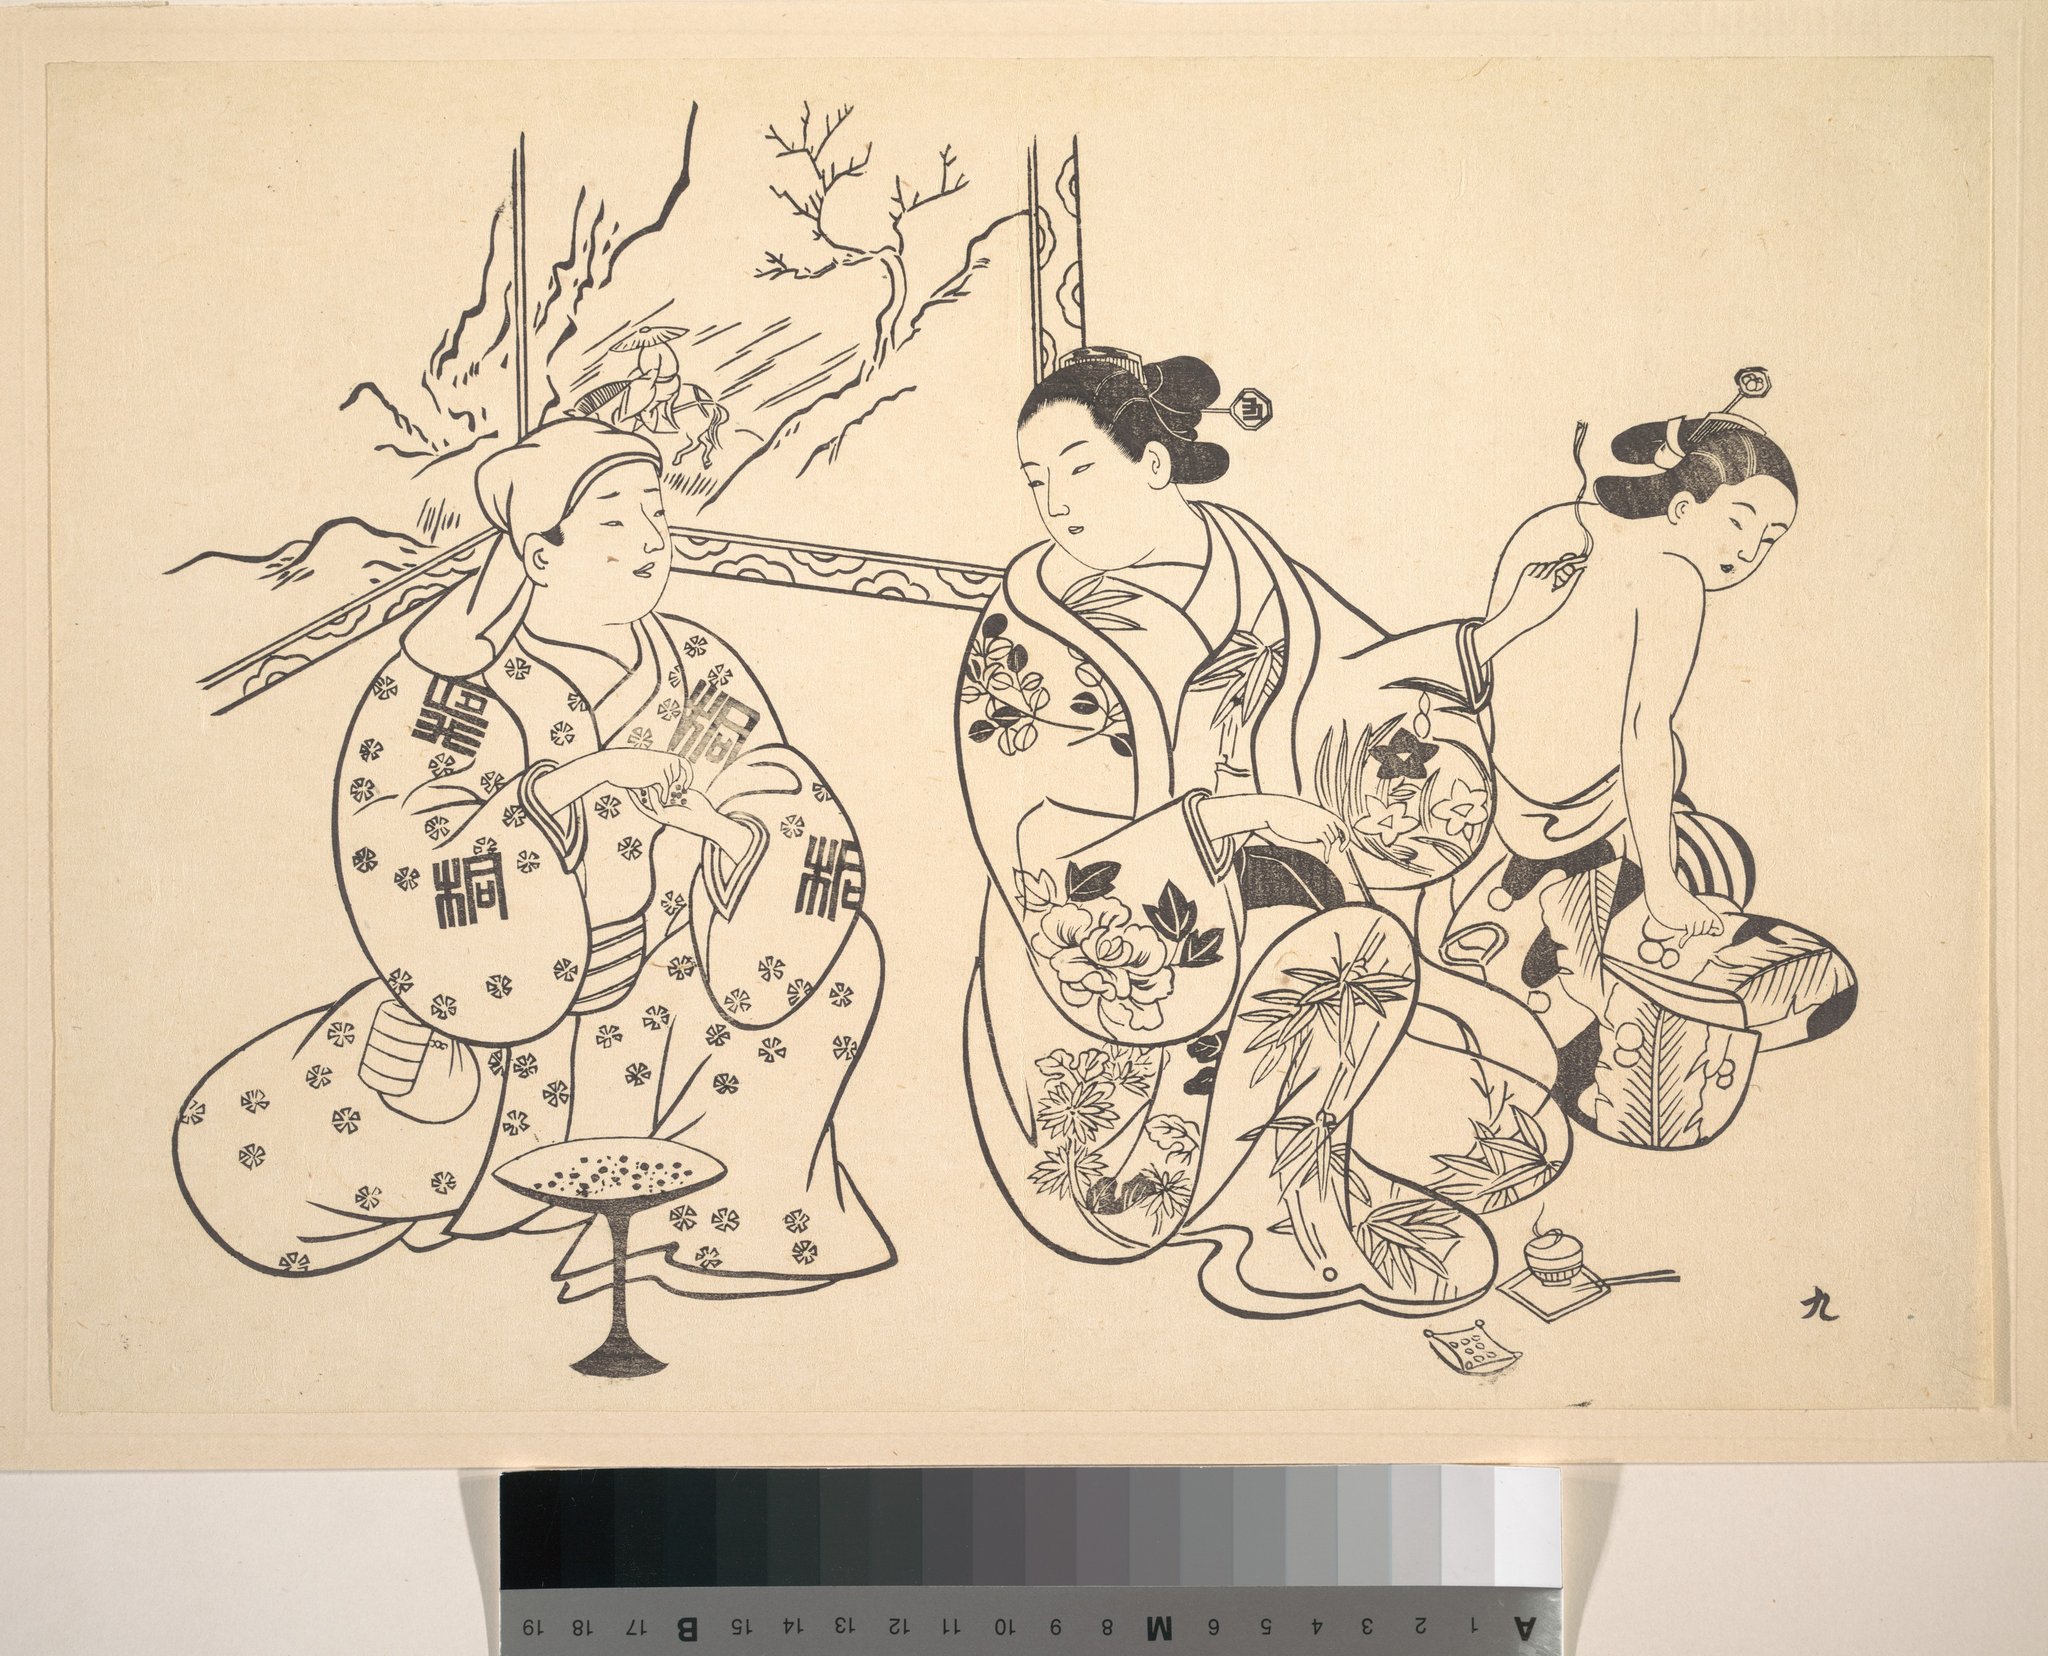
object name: print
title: An Oiran Seated in a Parlor Applies the Fire Treatment to the Bared Back of Another Woman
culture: japanese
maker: okumura masanobu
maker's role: artist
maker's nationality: japanese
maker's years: 1686-1764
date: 1868-1912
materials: ink, paper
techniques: woodblock print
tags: men,women